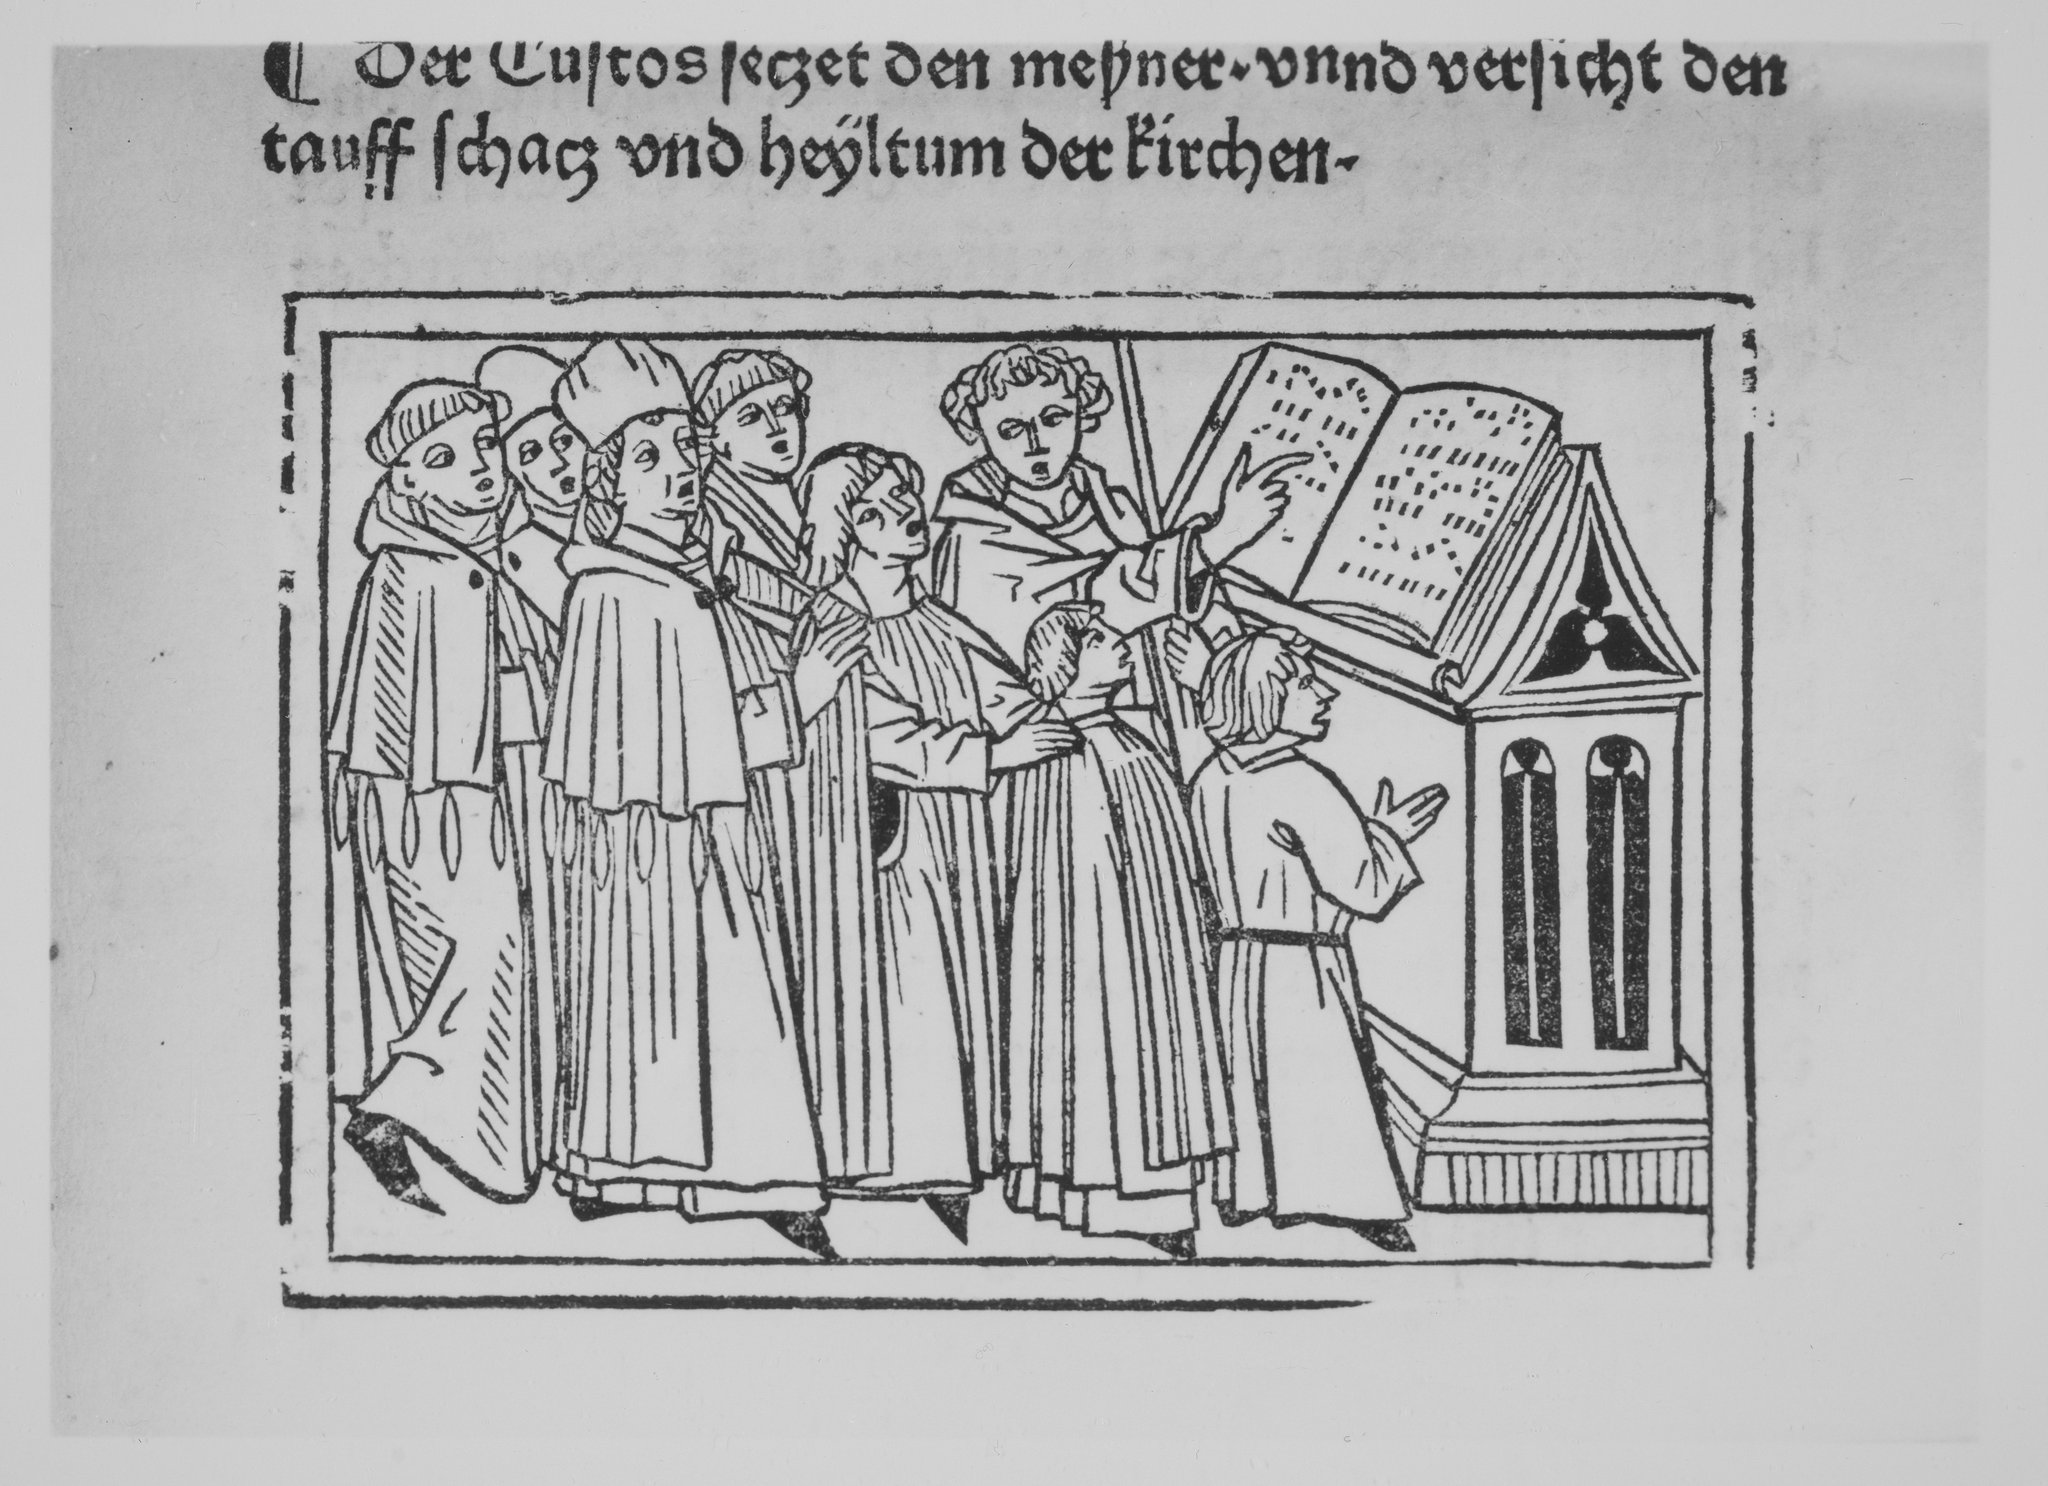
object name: book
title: Der Spiegel des Menschlichen lebens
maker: rodericus zamorensis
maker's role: author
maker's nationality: spanish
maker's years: 1404-1470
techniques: woodcut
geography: germany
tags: human figures,books